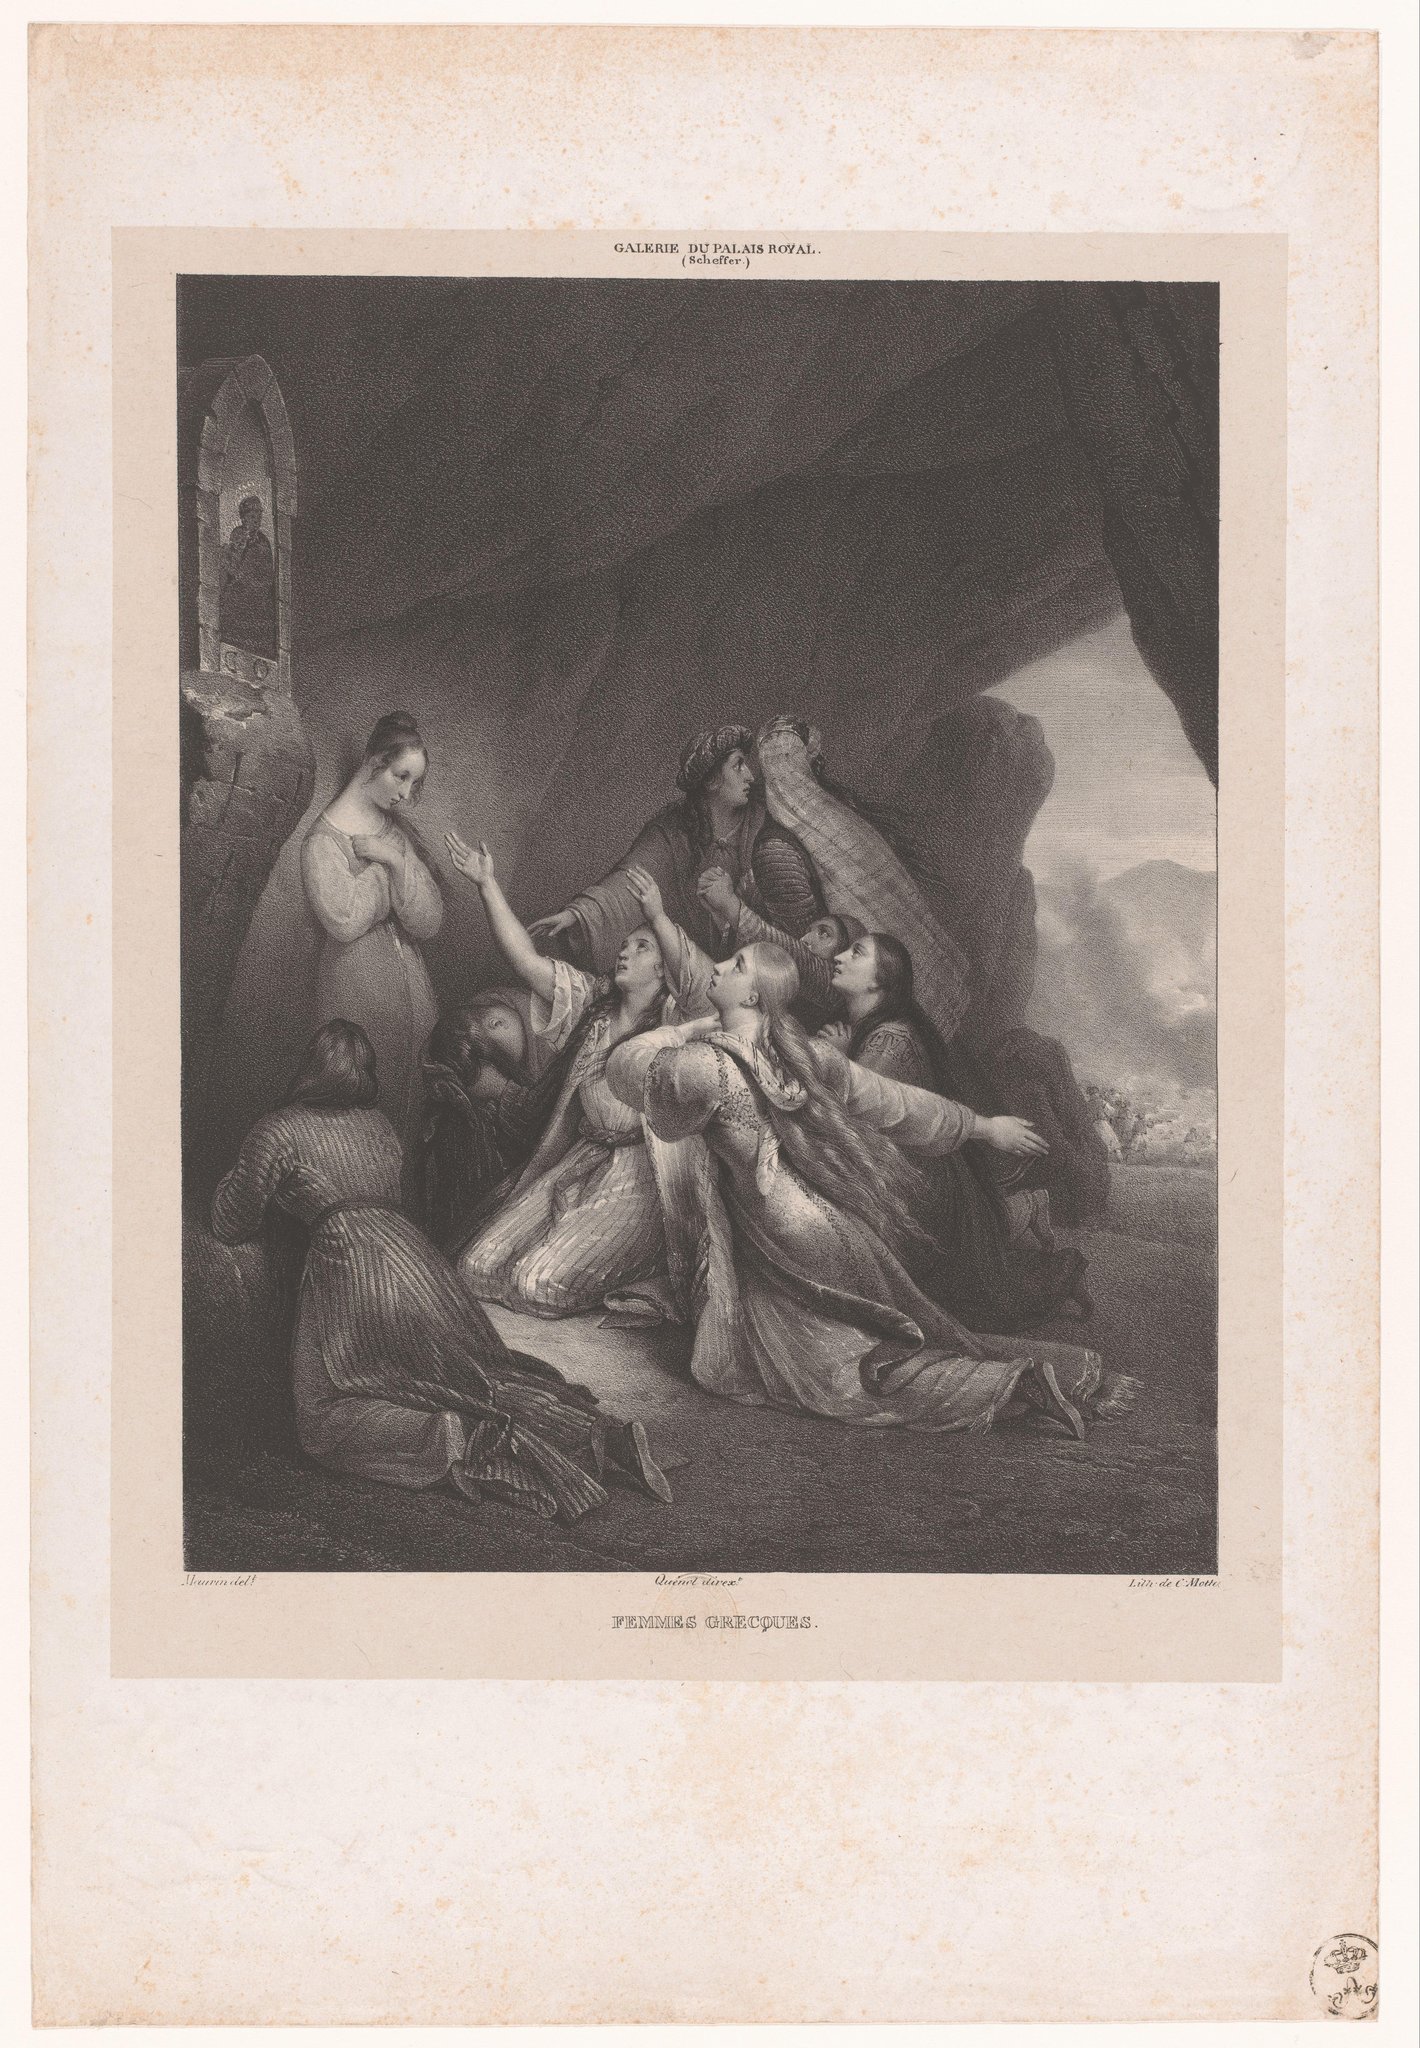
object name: print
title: Femmes grecques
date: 1824-1829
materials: paper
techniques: lithograph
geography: paris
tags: cave, grotto, the worship of god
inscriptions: check stamp: Lugt 1999d, collector's mark: Lugt 2228, collector's mark: Lugt 4780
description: Het schilderij hing in de galerie van het Palais Royal te Parijs. Onderdeel van een prentserie over de schilderijenverzameling van Lodewijk Filips, hertog van Orléans - de latere koning Lodewijk Filips I.